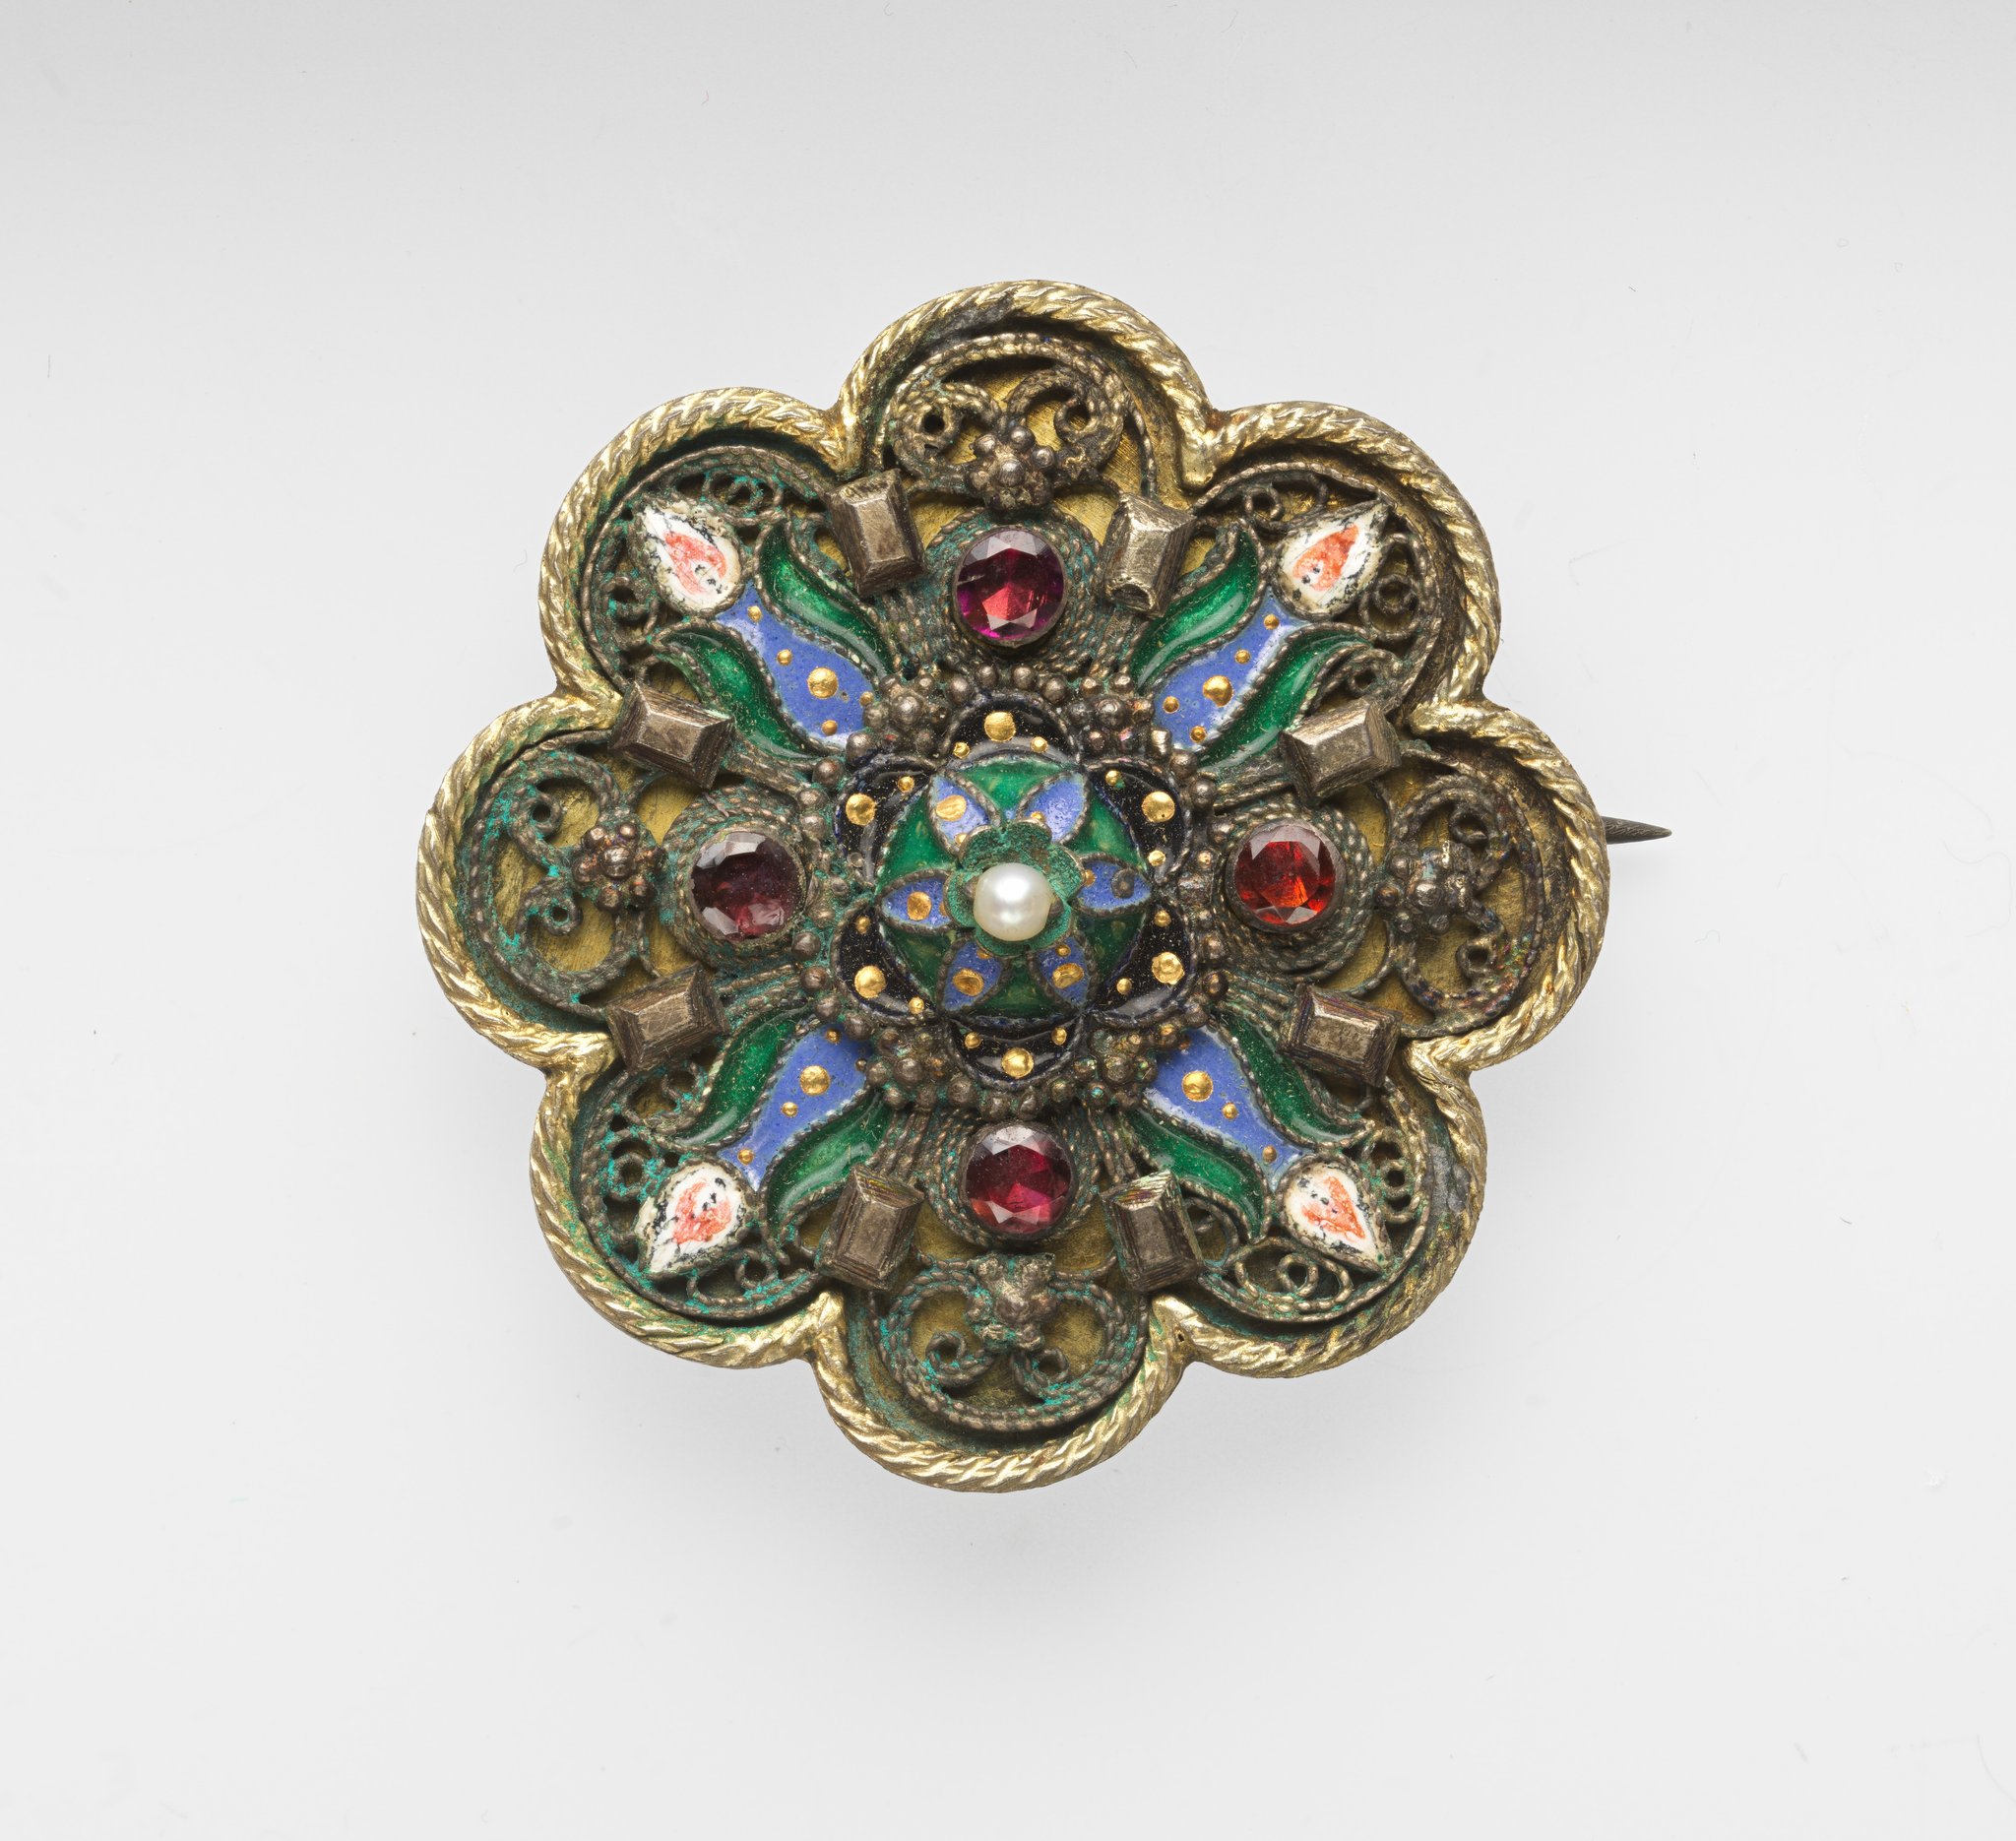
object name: brooch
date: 1801-1900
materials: silver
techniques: enamel, gilding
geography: iran